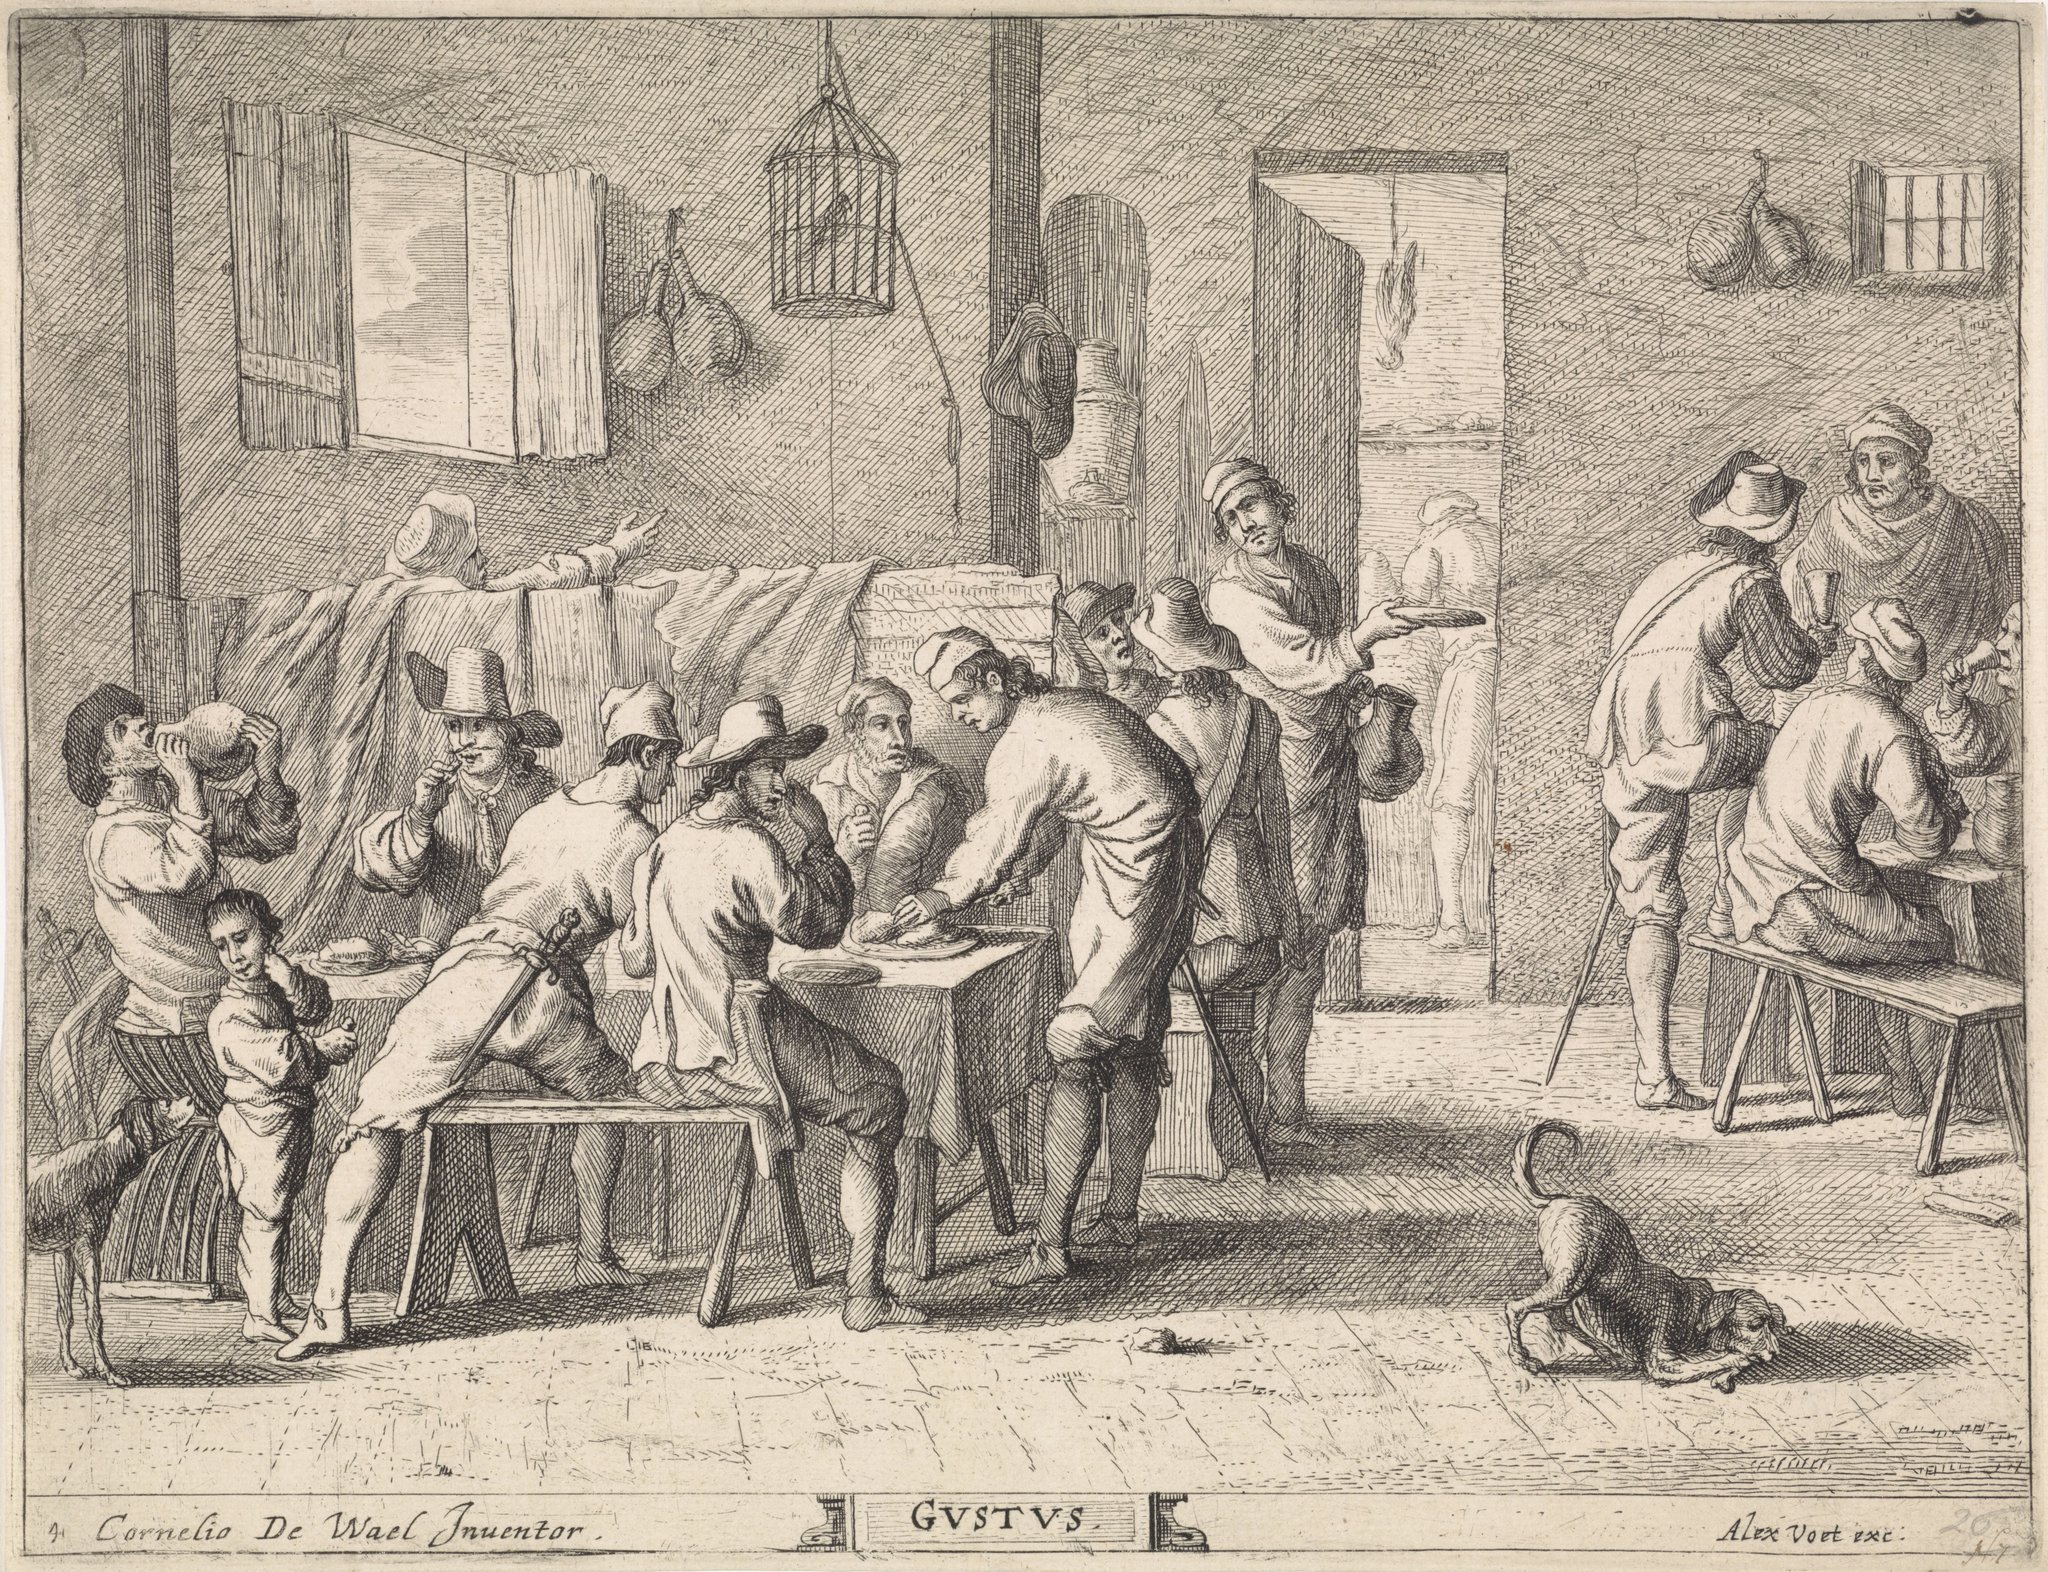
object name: print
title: Vijf zintuigen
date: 1628-1689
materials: paper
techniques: engraving, etching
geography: antwerp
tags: taste, tasting (one of the five senses)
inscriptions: collector's mark: Lugt 2228, number: ‘N.1’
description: Interieur van een herberg. Mannen zitten rond tafels te eten en te drinken. In het midden staat een ober, achter hem is de keuken net zichtbaar. Op de voorgrond een hond die op een bot kluift.